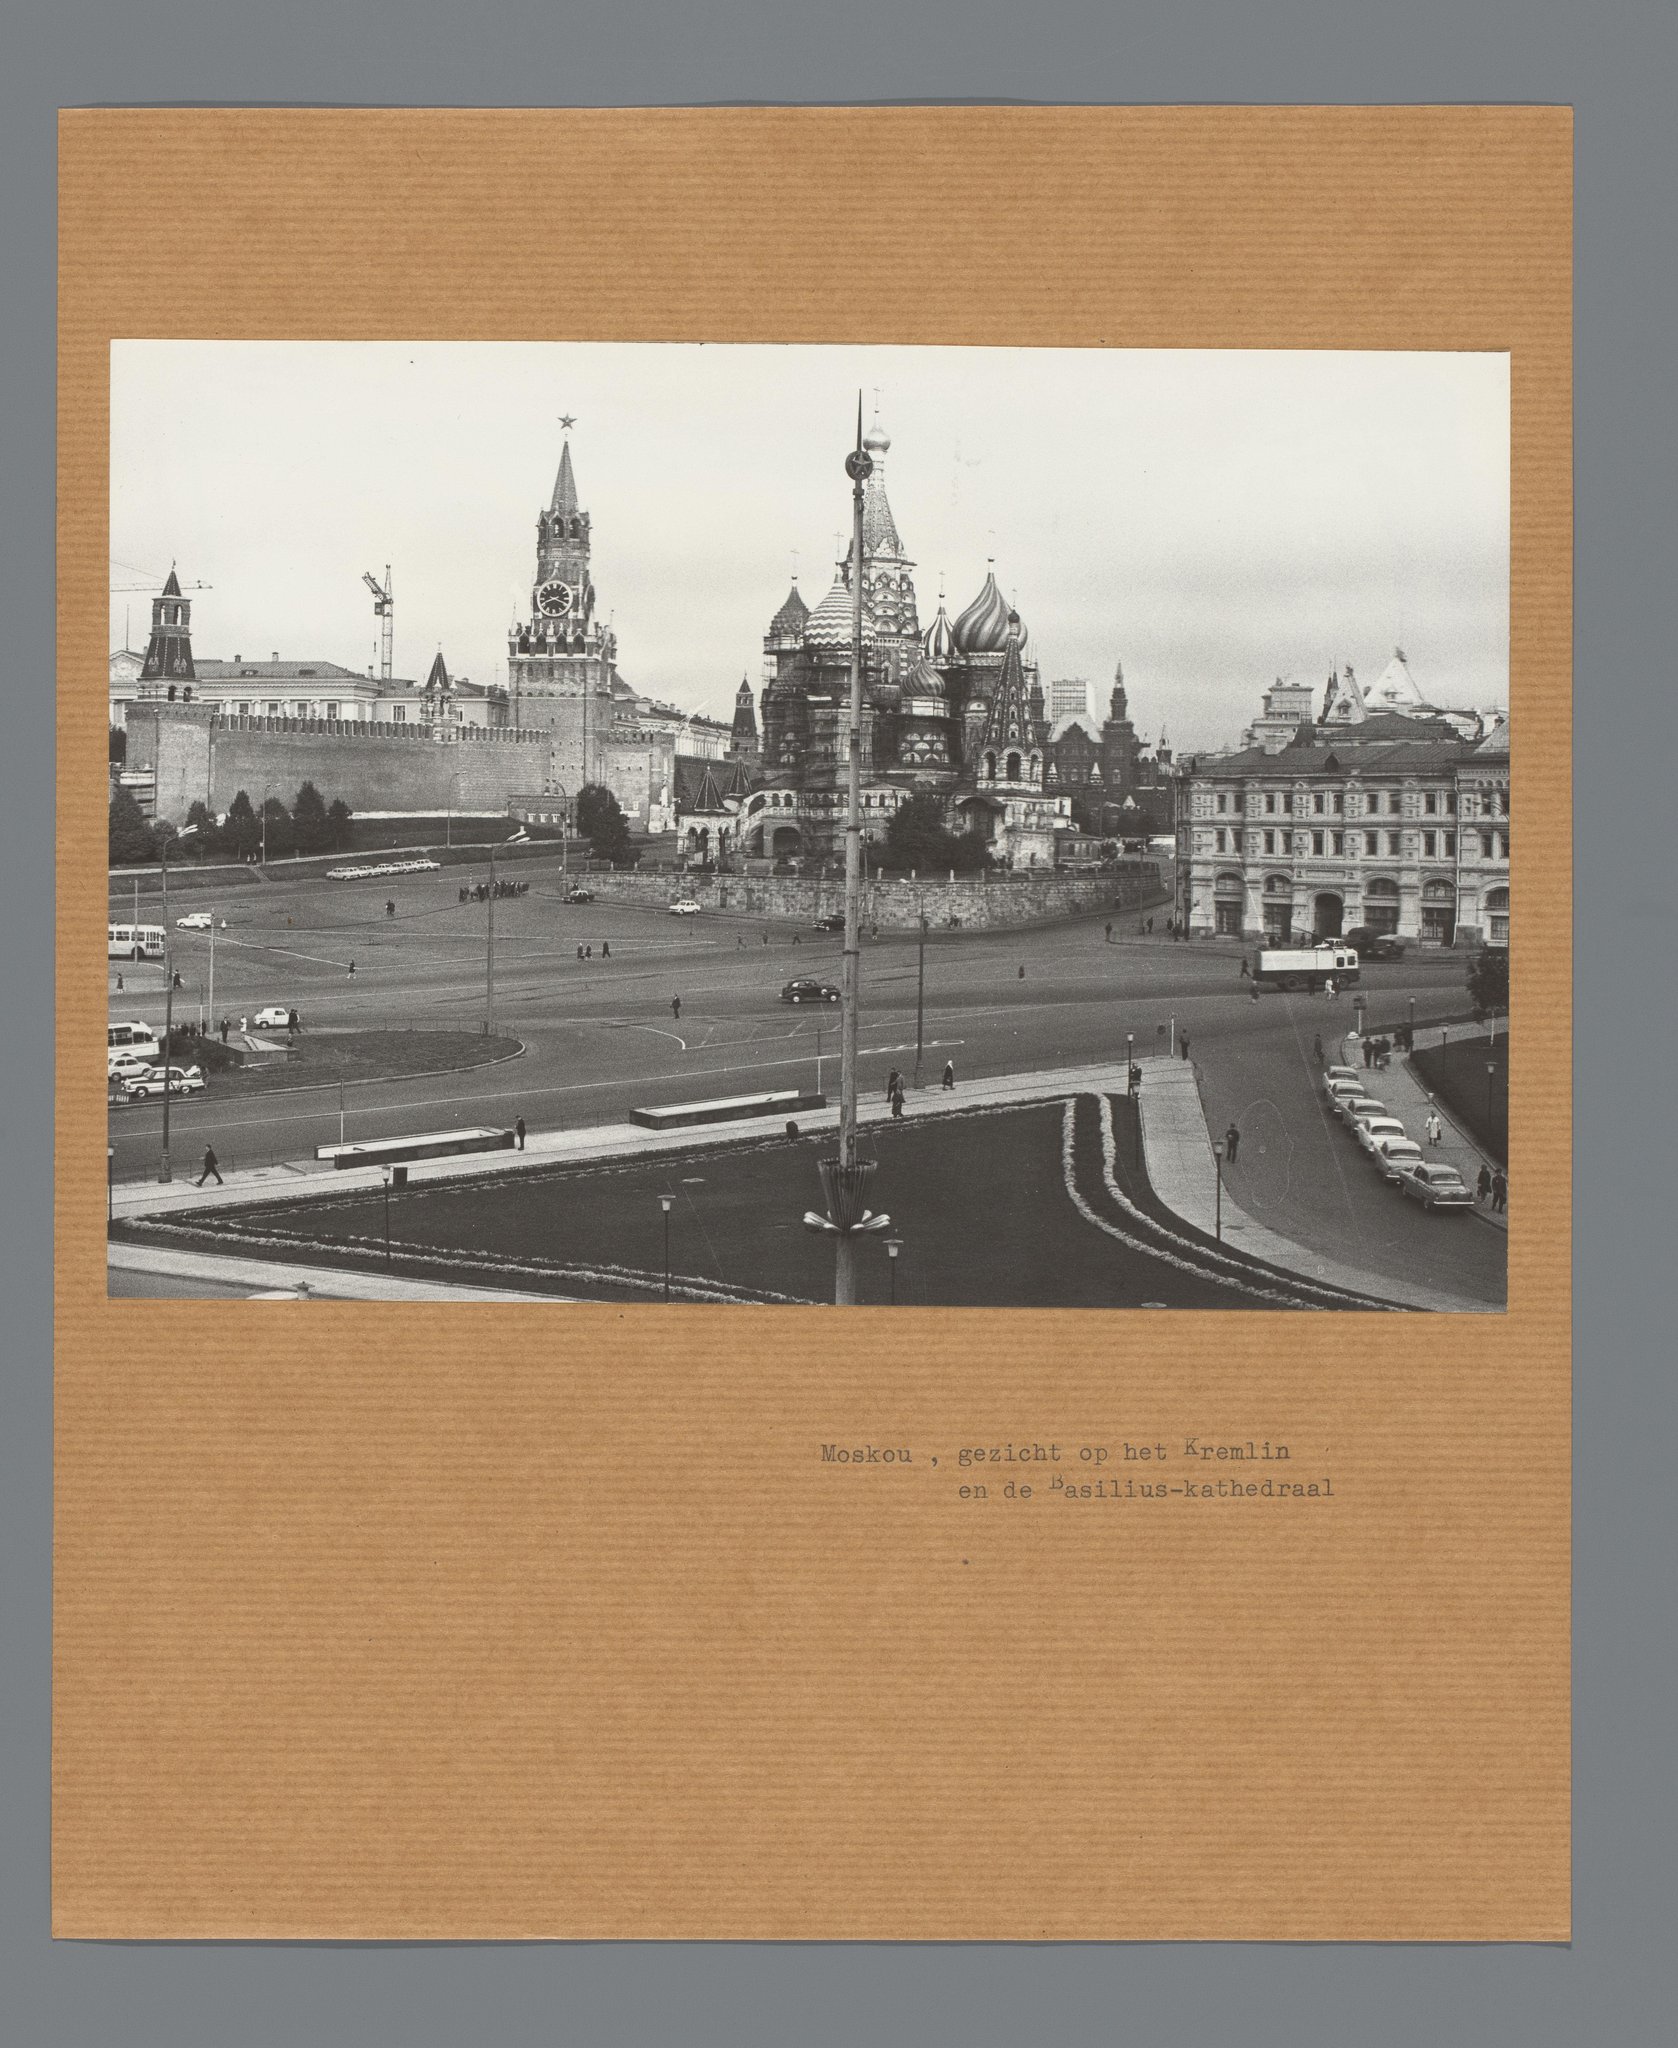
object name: photograph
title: Moskou, gezicht op het Kremlin en de Basilius-kathedraal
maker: Anonymous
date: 1880-1930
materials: photographic support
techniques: gelatin silver print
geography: russia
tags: kremlin